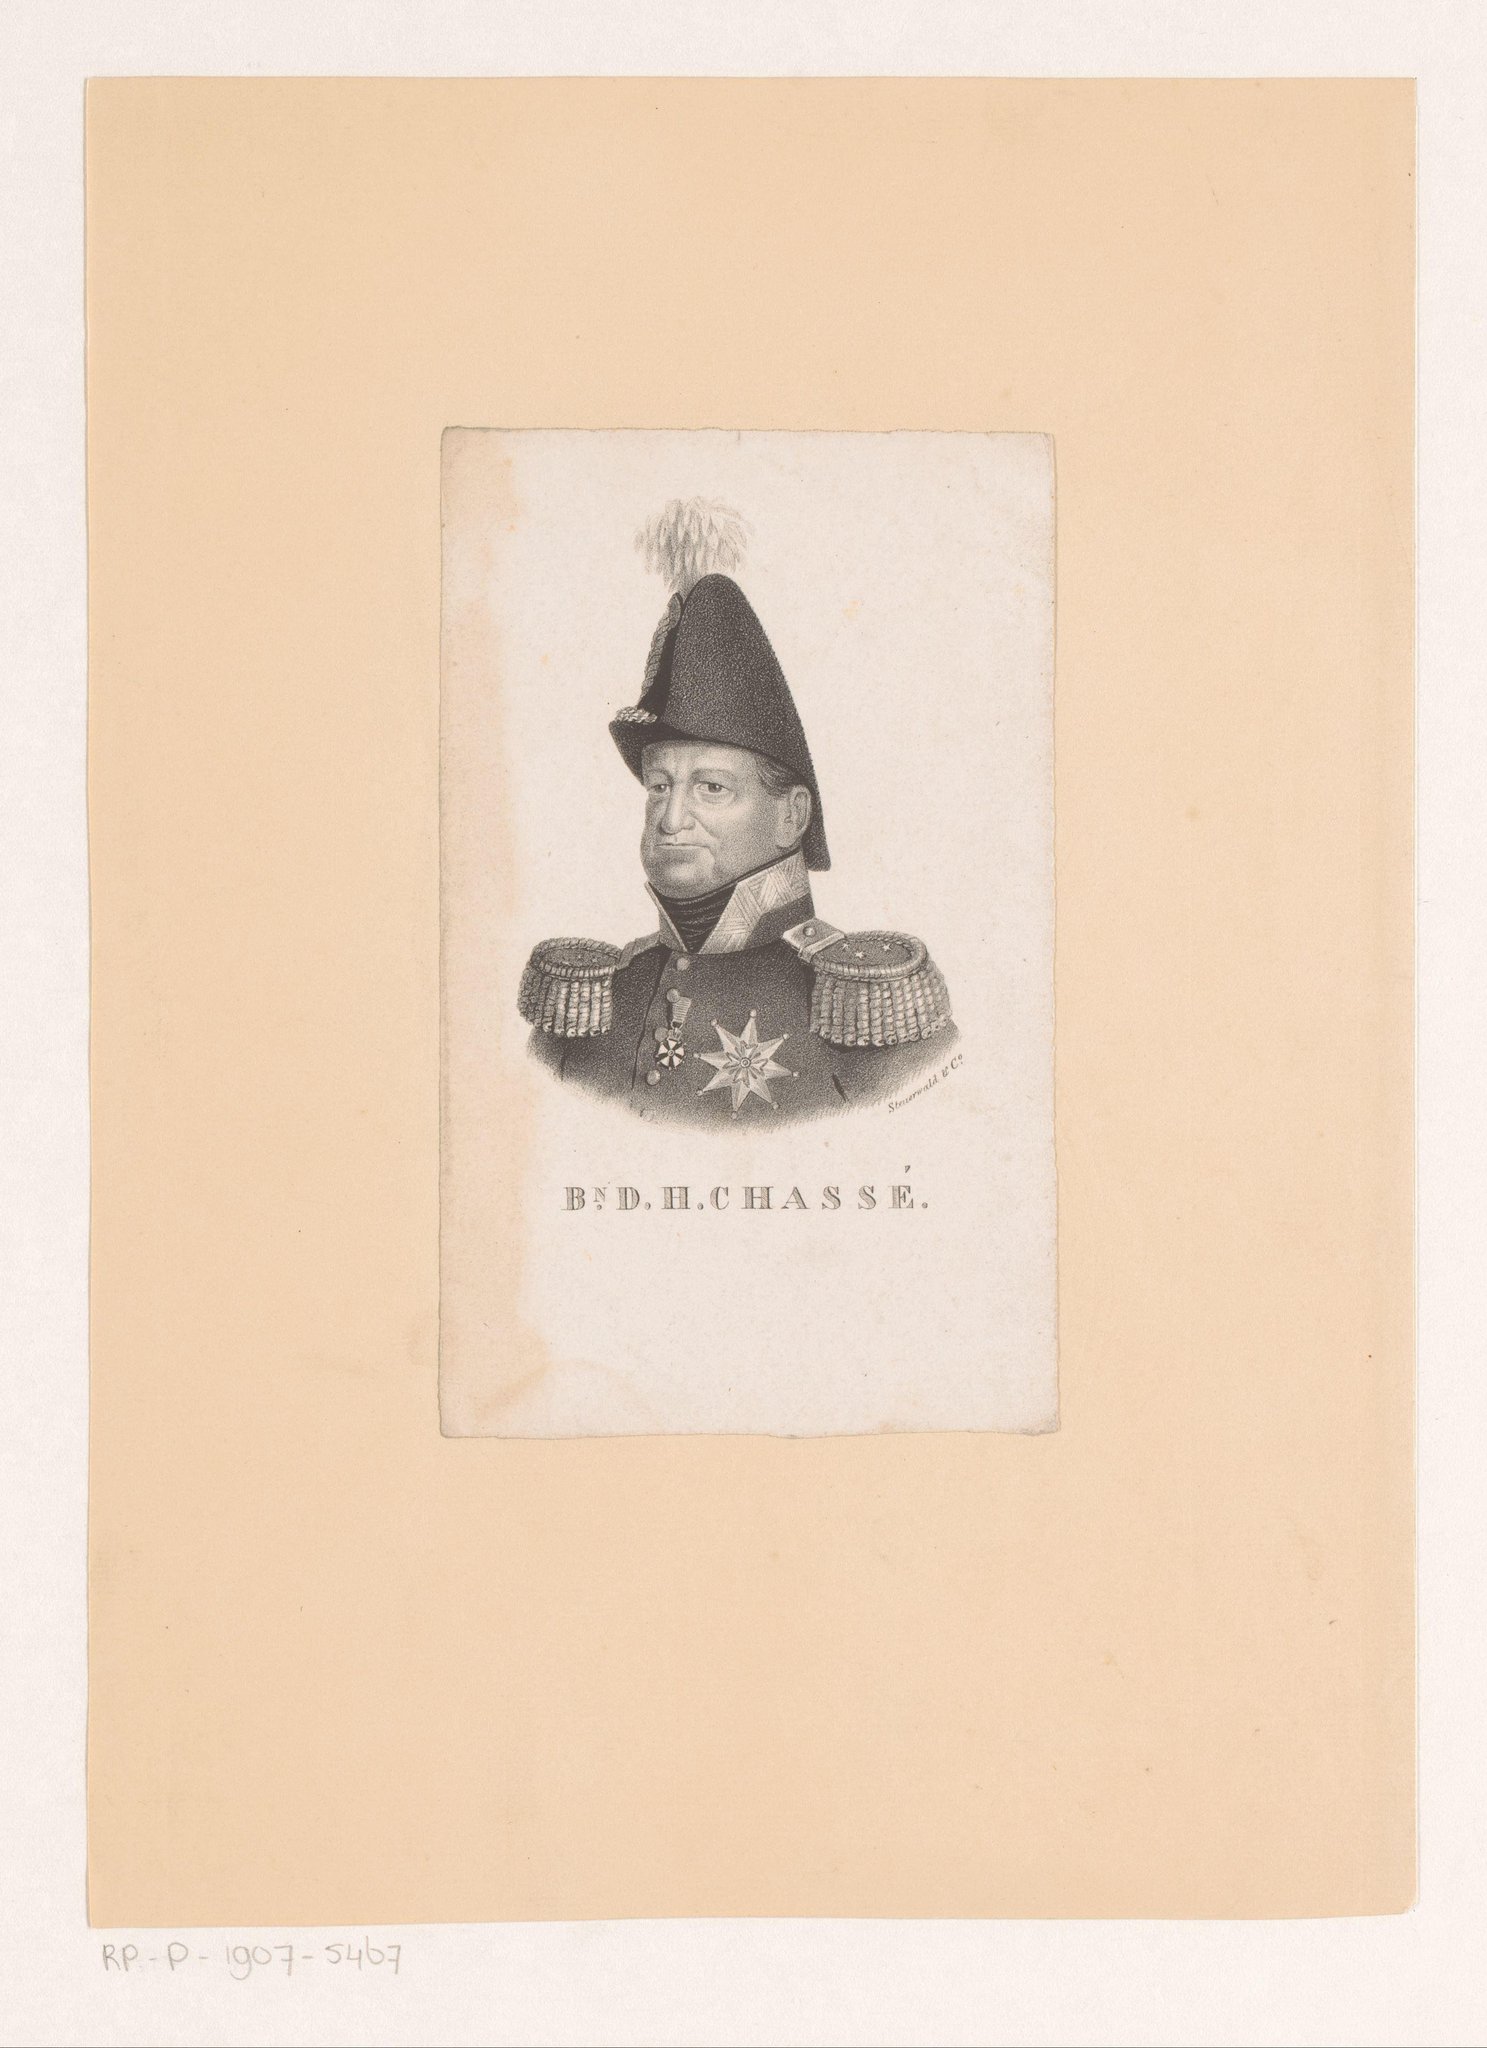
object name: print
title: Portret van David Hendrik Chassé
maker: Anonymous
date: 1826-1833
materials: paper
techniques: lithograph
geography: the hague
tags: david hendrik baron chassé, historical persons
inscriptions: watermark, collector's mark: Lugt 2228